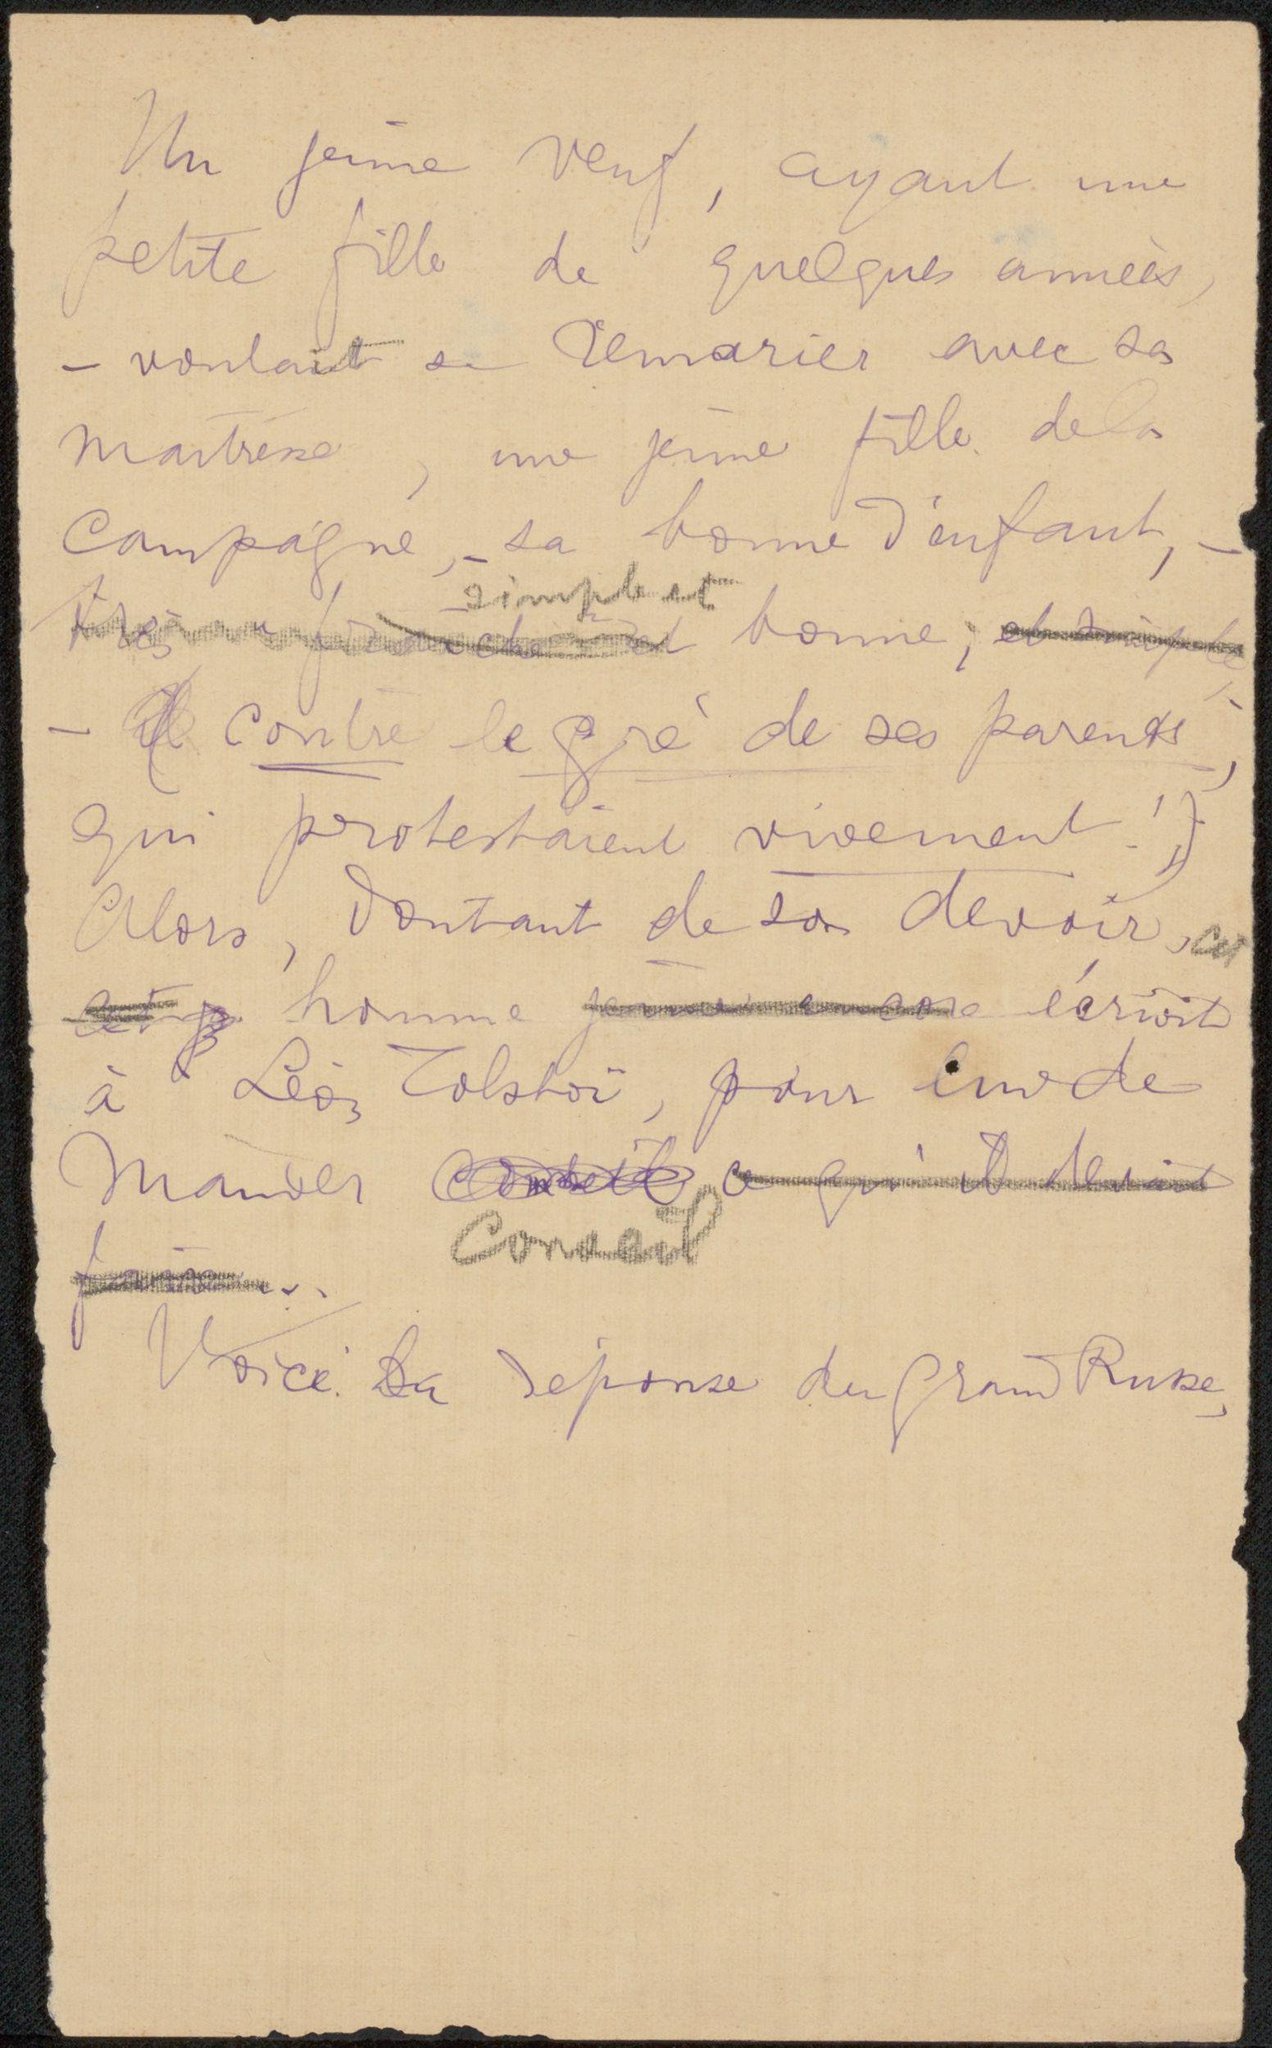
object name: aantekening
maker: philip zilcken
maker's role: draughtsman, painter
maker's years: 1857-1930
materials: ink, paper, pencil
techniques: pen, writing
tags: lev tolstoj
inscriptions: collector's mark: ‘RPK’